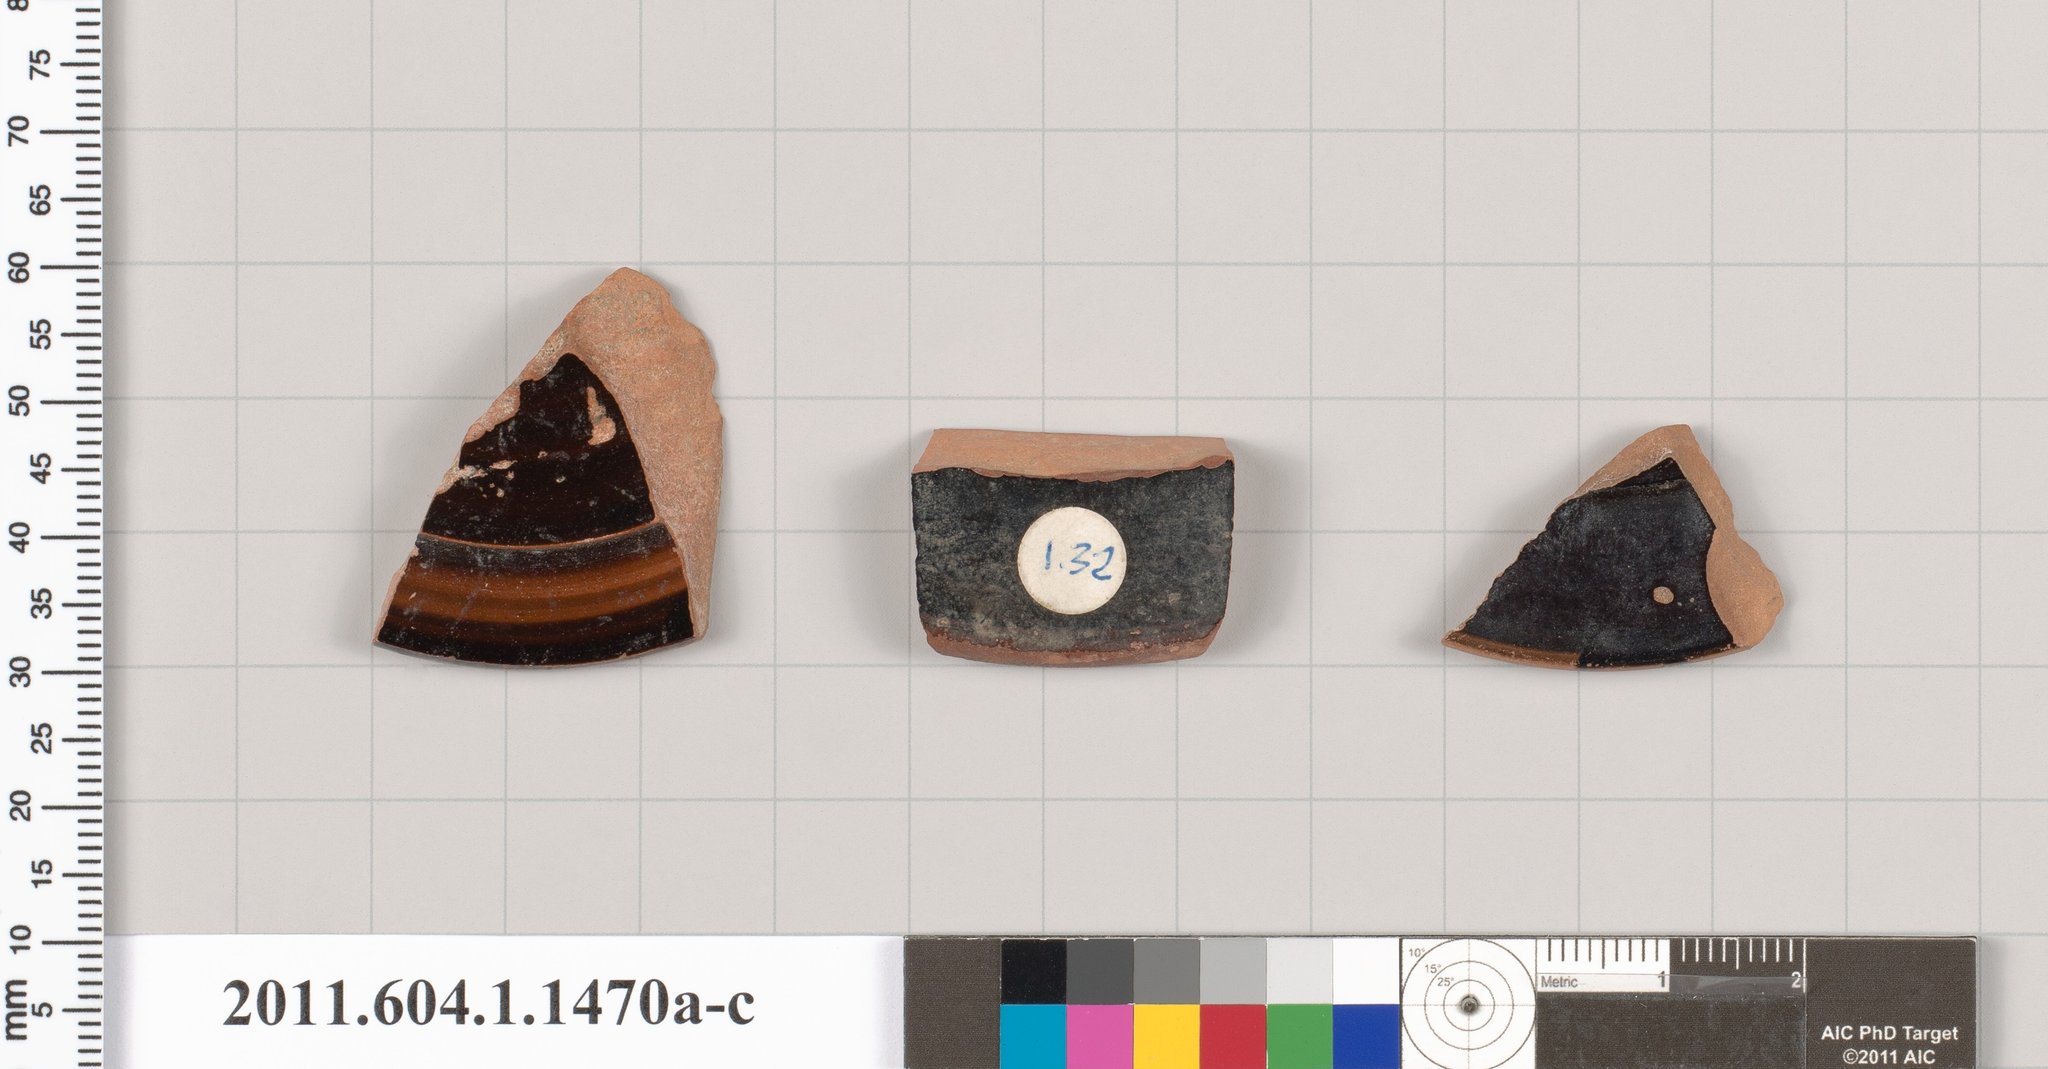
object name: kylix fragment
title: Terracotta fragments of kylikes (drinking cups)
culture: greek, attic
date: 500-401 BCE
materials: terracotta